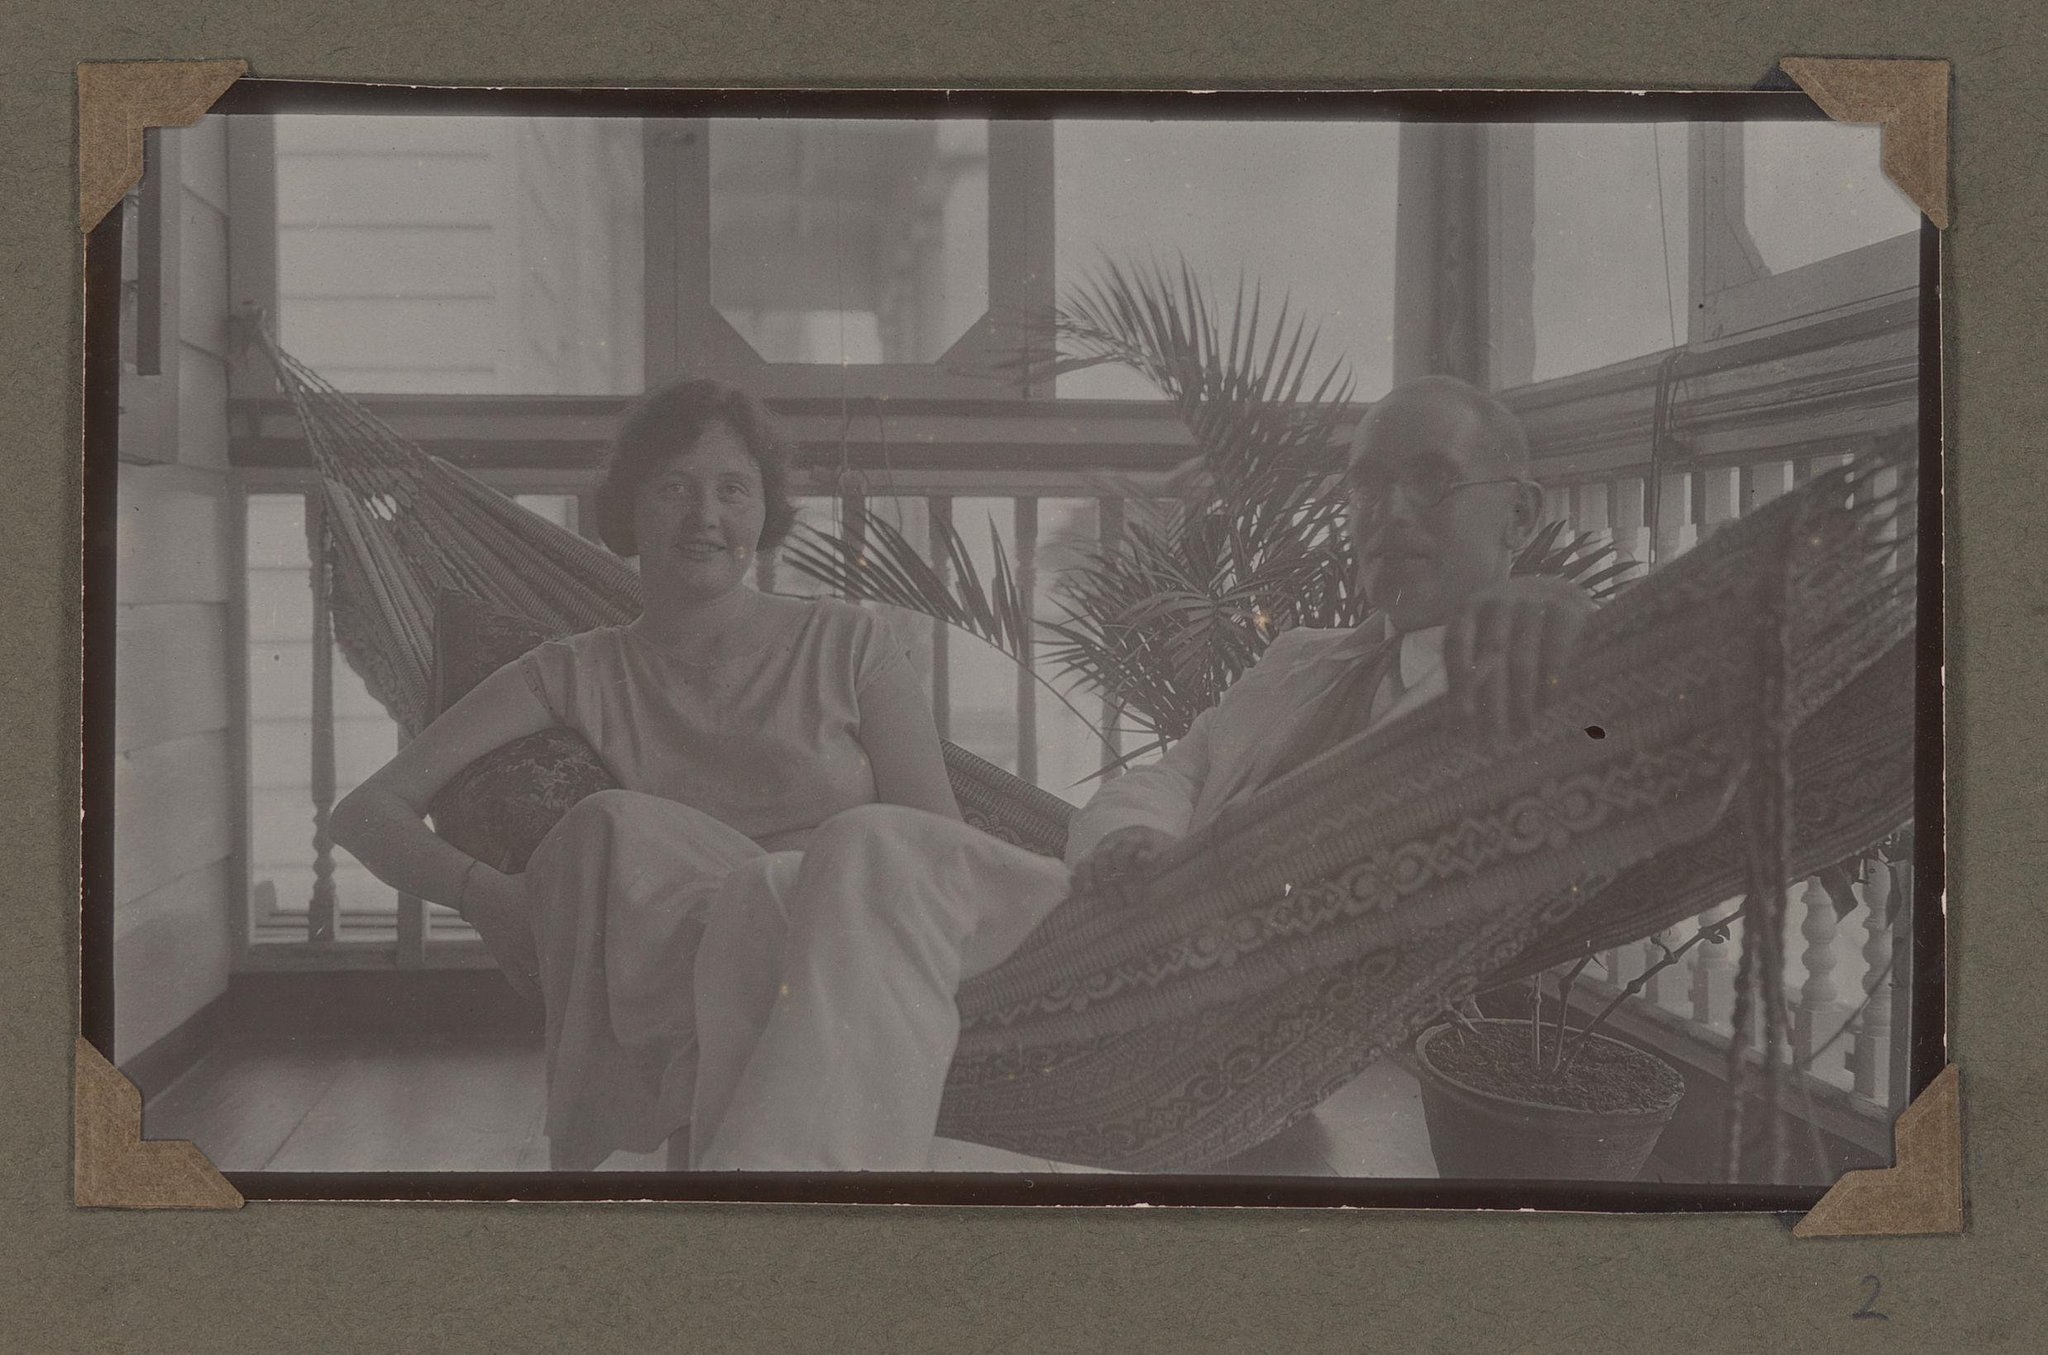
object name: photograph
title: Familiefoto van het echtpaar Jetten te Moengo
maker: Anonymous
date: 1925-1927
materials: photographic support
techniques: photography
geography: suriname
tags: jetten, familie, moengo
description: Familiefoto van het echtpaar Jetten in een hangmat in hun huis te Moengo. Foto op een bladzijde van een los albumblad. Onderdeel van het ensemble met foto's van de familie van ingenieur Jetten in de mijnbouwstad Moengo in Suriname.